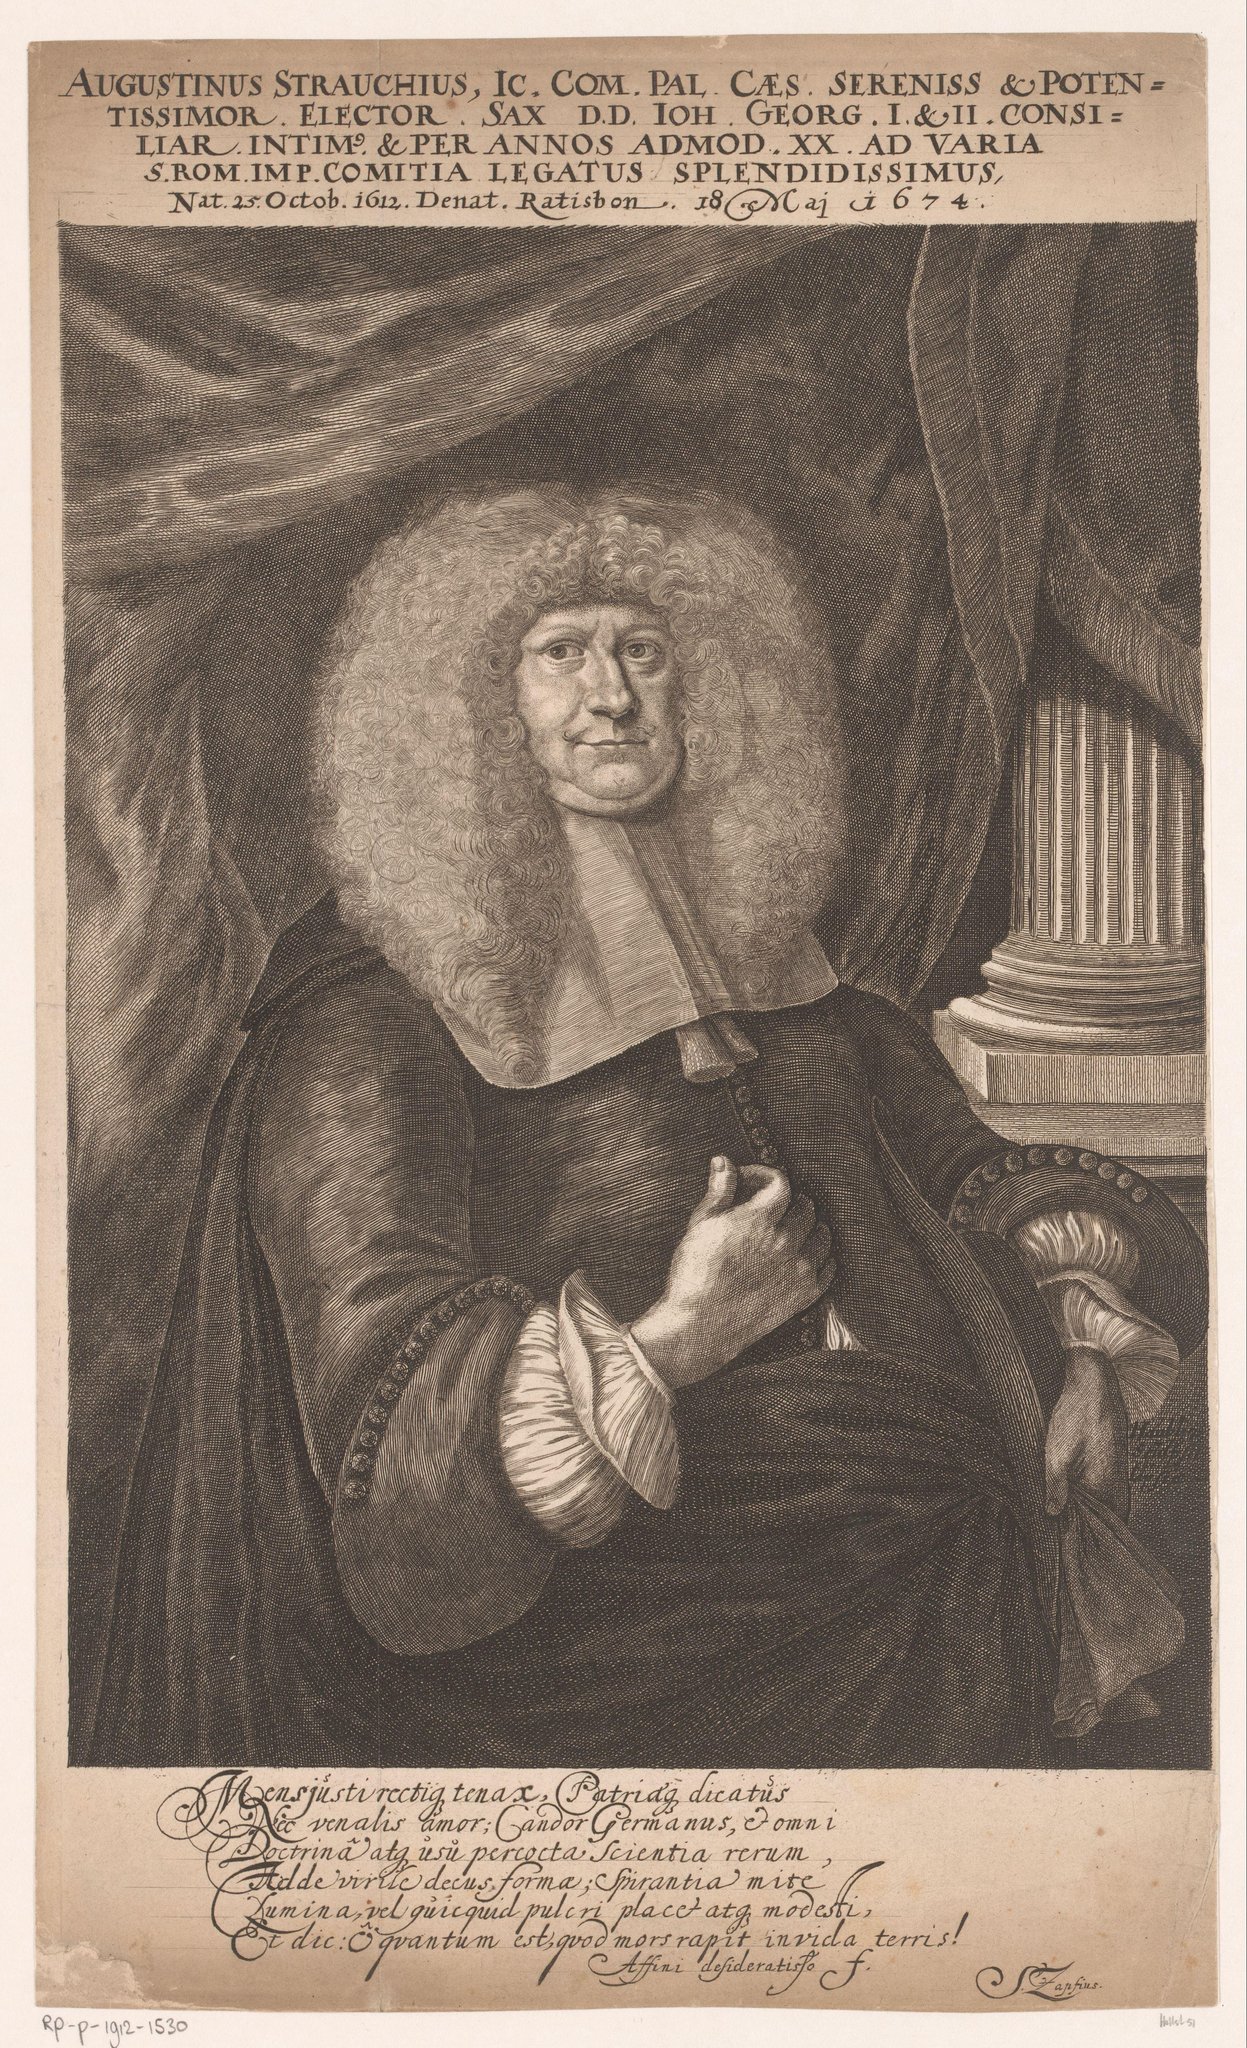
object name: print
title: Portret van Augustin Strauch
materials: paper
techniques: engraving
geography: leipzig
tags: column, pillar ~ architecture, historical persons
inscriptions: collector's mark: Lugt 2228